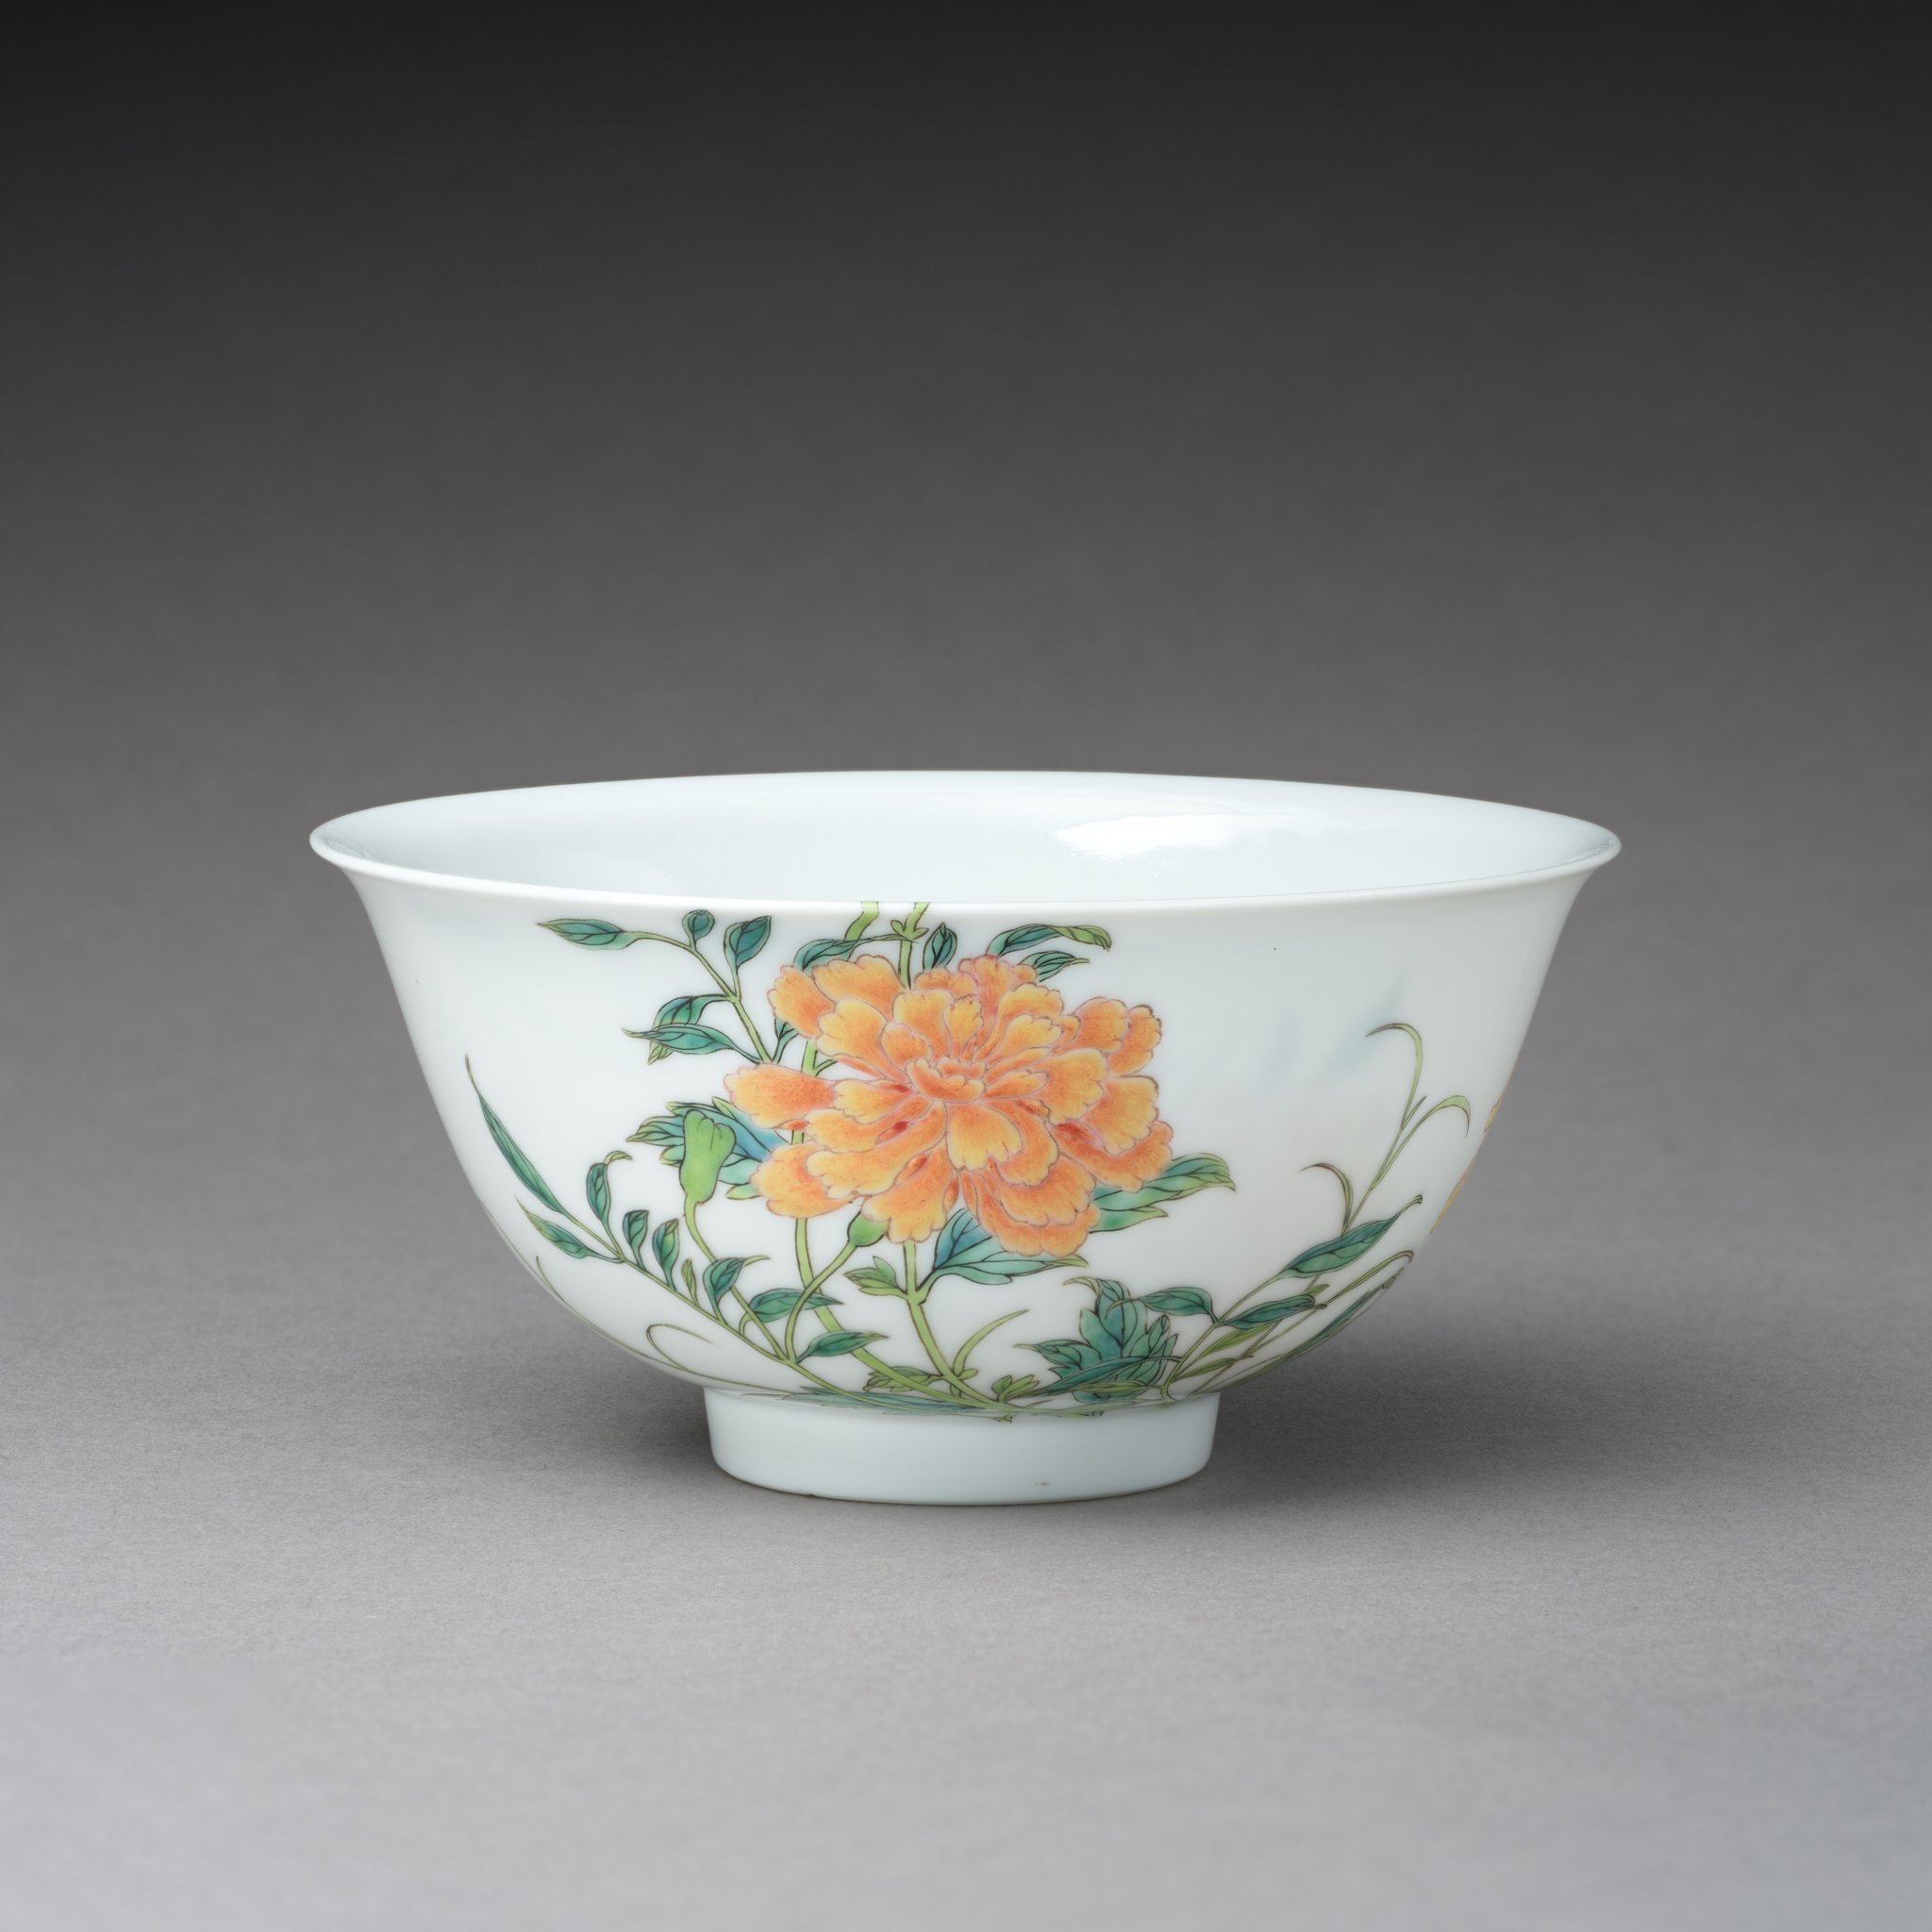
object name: bowl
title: Bowl with flowers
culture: chinese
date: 1701-1733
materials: enamel, porcelain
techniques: overglaze, painting, polychrome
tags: flowers